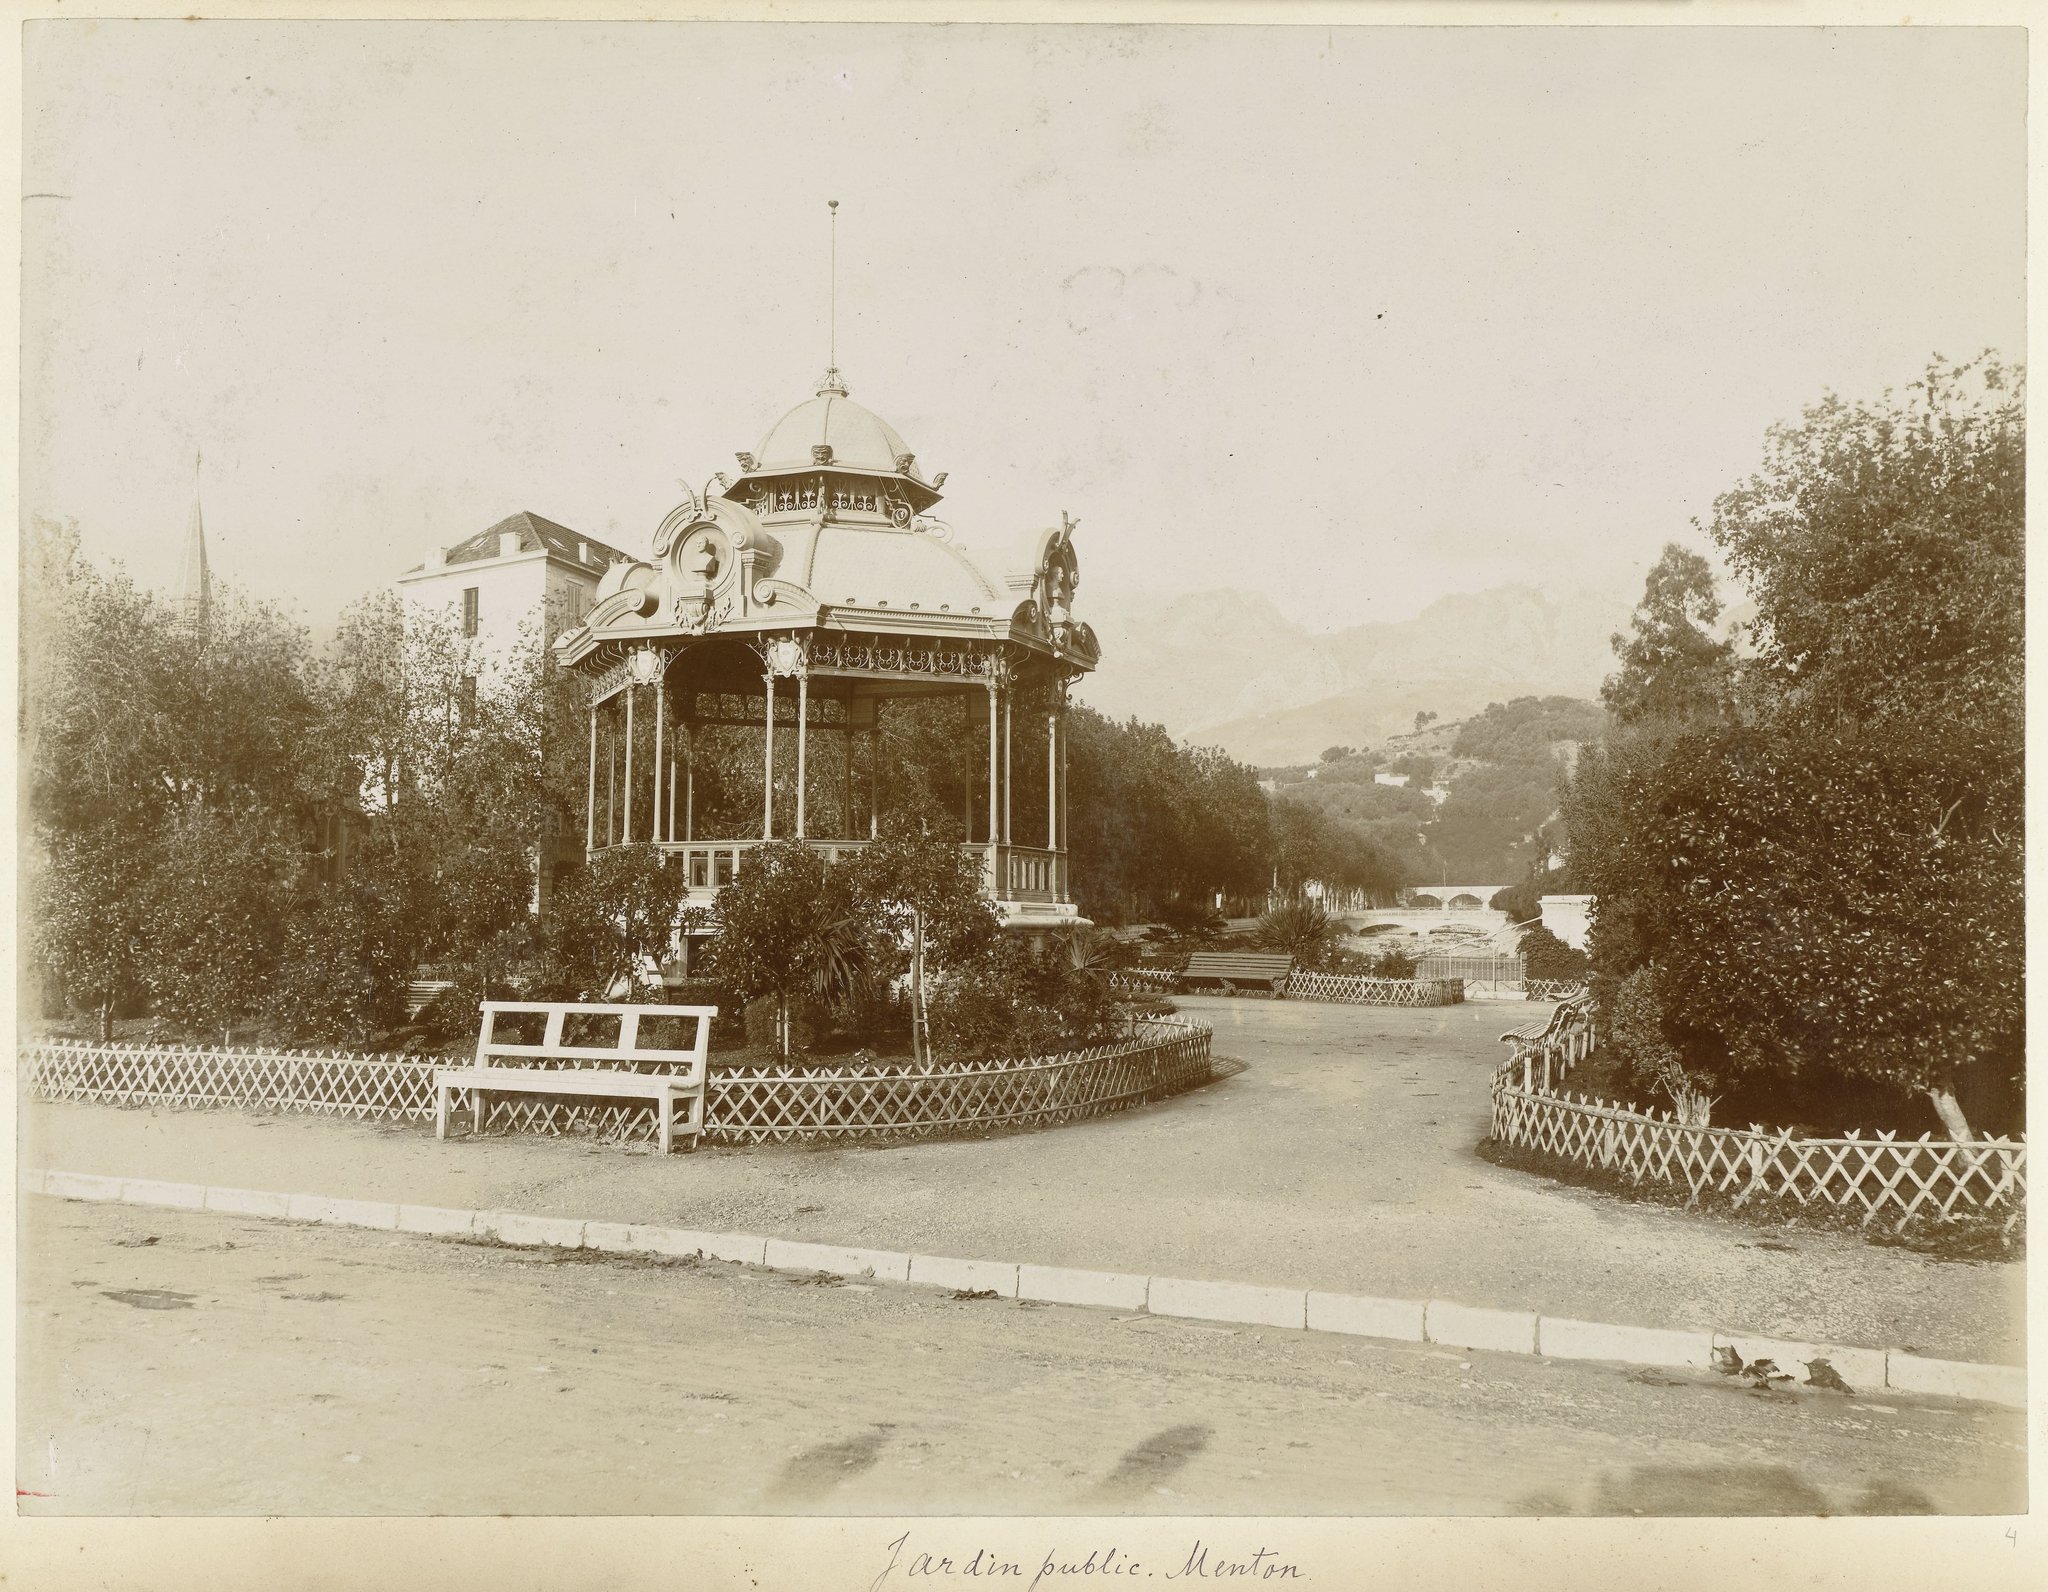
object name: photograph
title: Stadstuin, open voor publiek, Menton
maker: henry pauw van wieldrecht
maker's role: fotograaf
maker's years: 1863-1912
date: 1886-1896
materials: cardboard, photographic support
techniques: albumen print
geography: france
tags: menton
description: Een openbare tuin of park in Menton met daarbinnen een kleine koepeloverkapping.